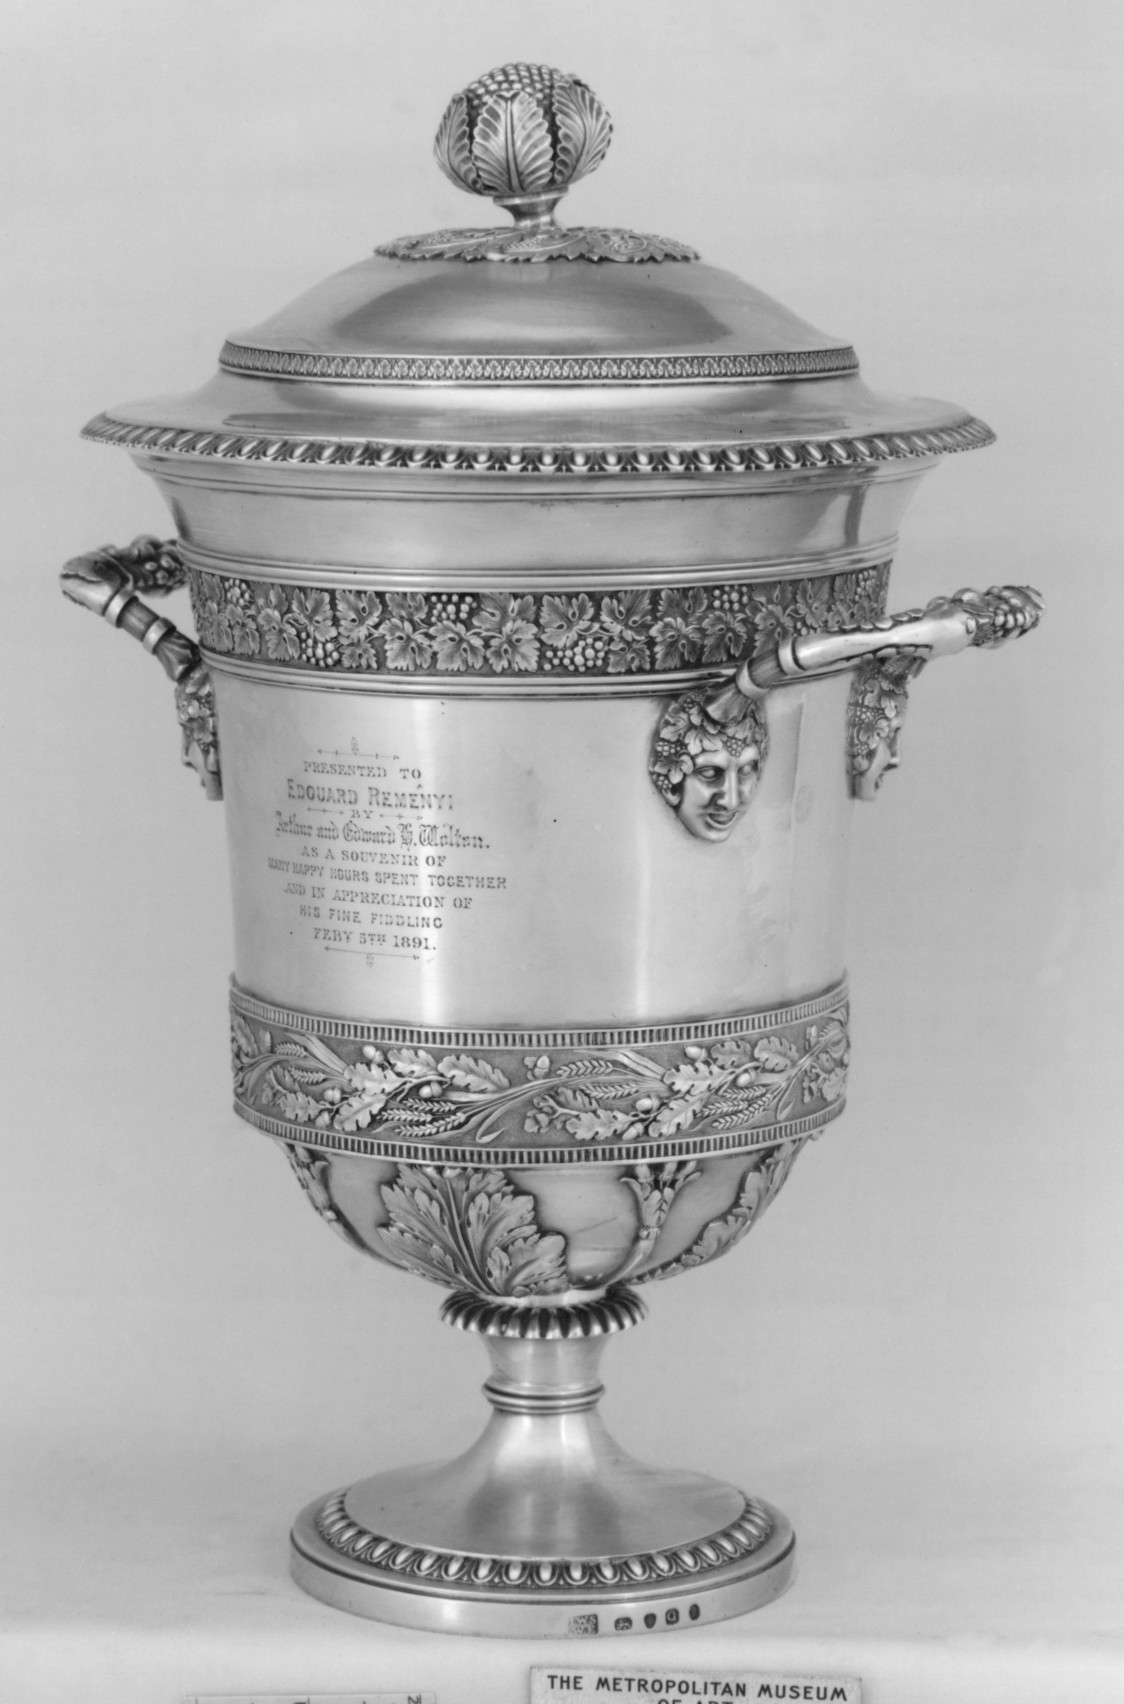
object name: vase with cover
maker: joseph william story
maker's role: maker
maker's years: 1803-1813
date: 1811-1812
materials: silver